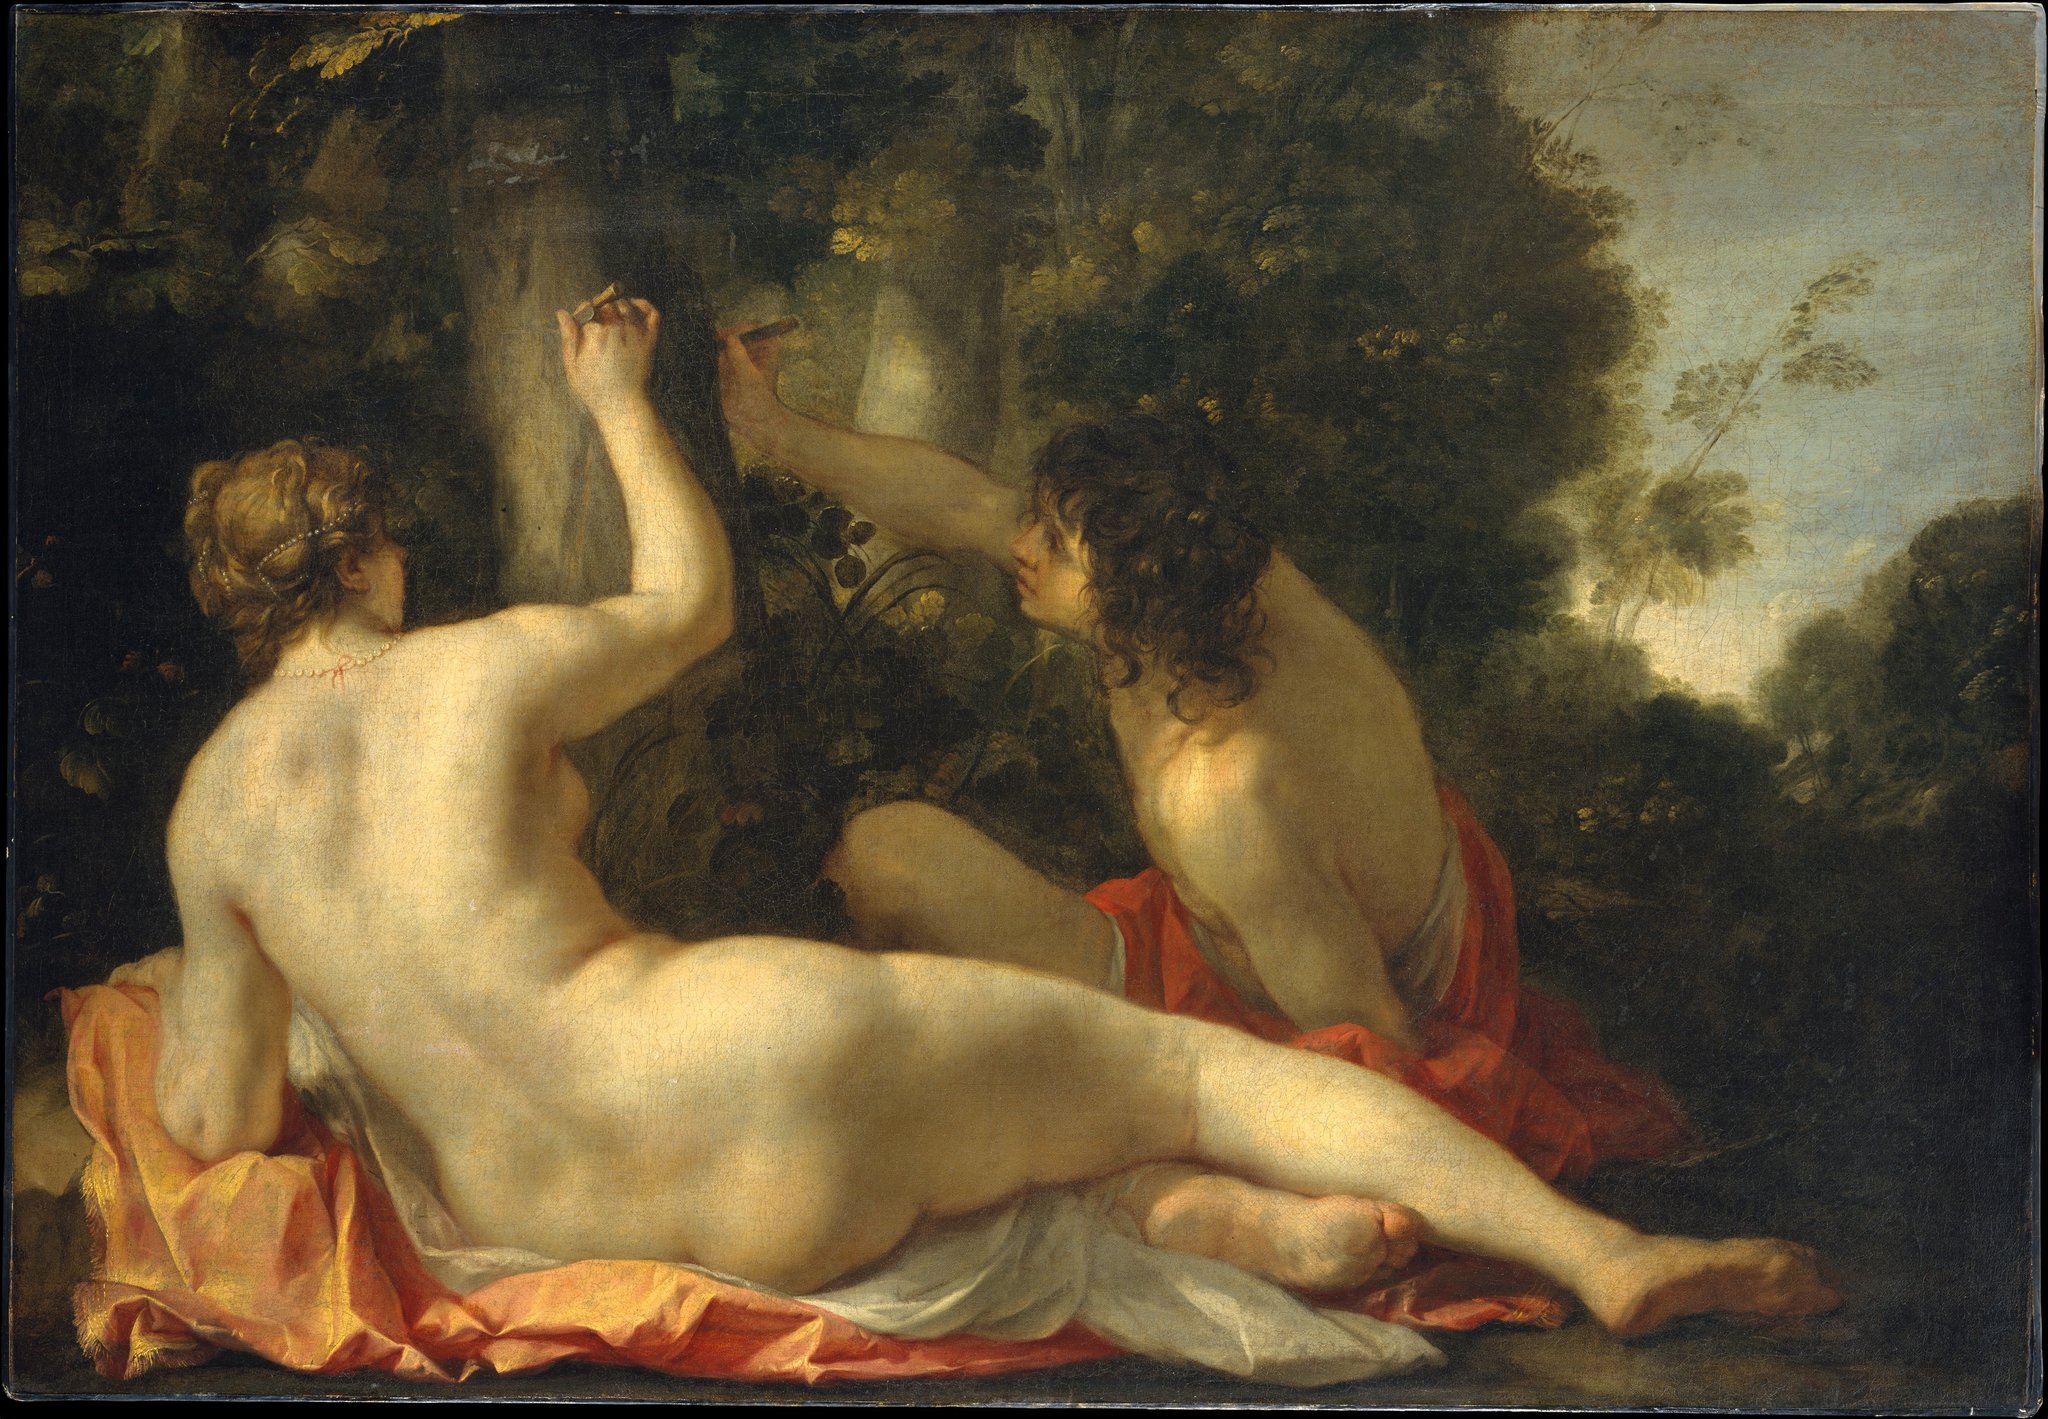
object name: painting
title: Angelica and Medoro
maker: jacques blanchard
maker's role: artist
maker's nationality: french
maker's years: 1600-1638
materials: canvas, oil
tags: couples,male nudes,female nudes